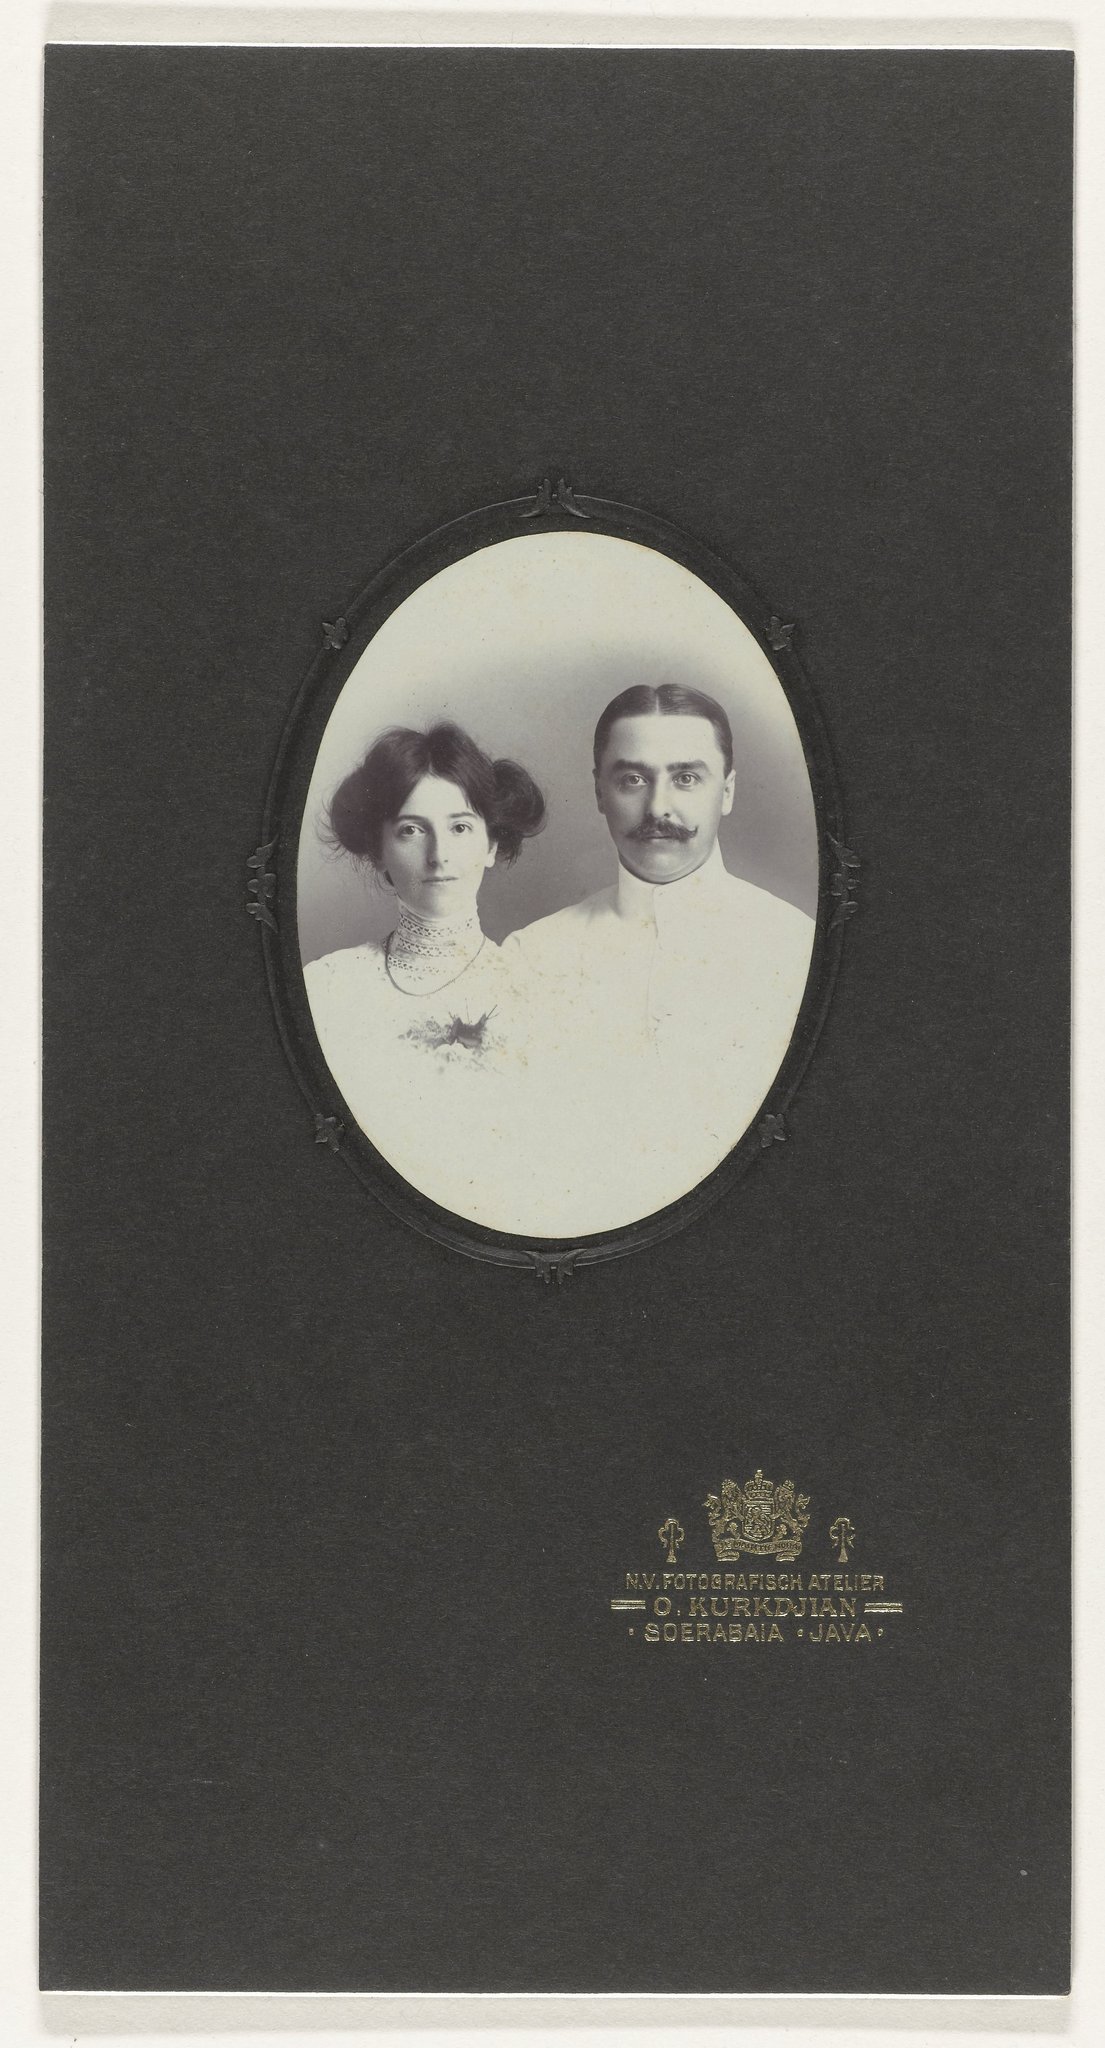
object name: photograph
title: Het echtpaar Letterie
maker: onnes kurkdjian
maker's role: fotograaf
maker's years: 1851-1903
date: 1913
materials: photographic support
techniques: photography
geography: surabaya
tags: surabaya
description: Het echtpaar Letterie genomen in fotostudio O. Kurkdjian in Soerabaia, in origineel hoesje.